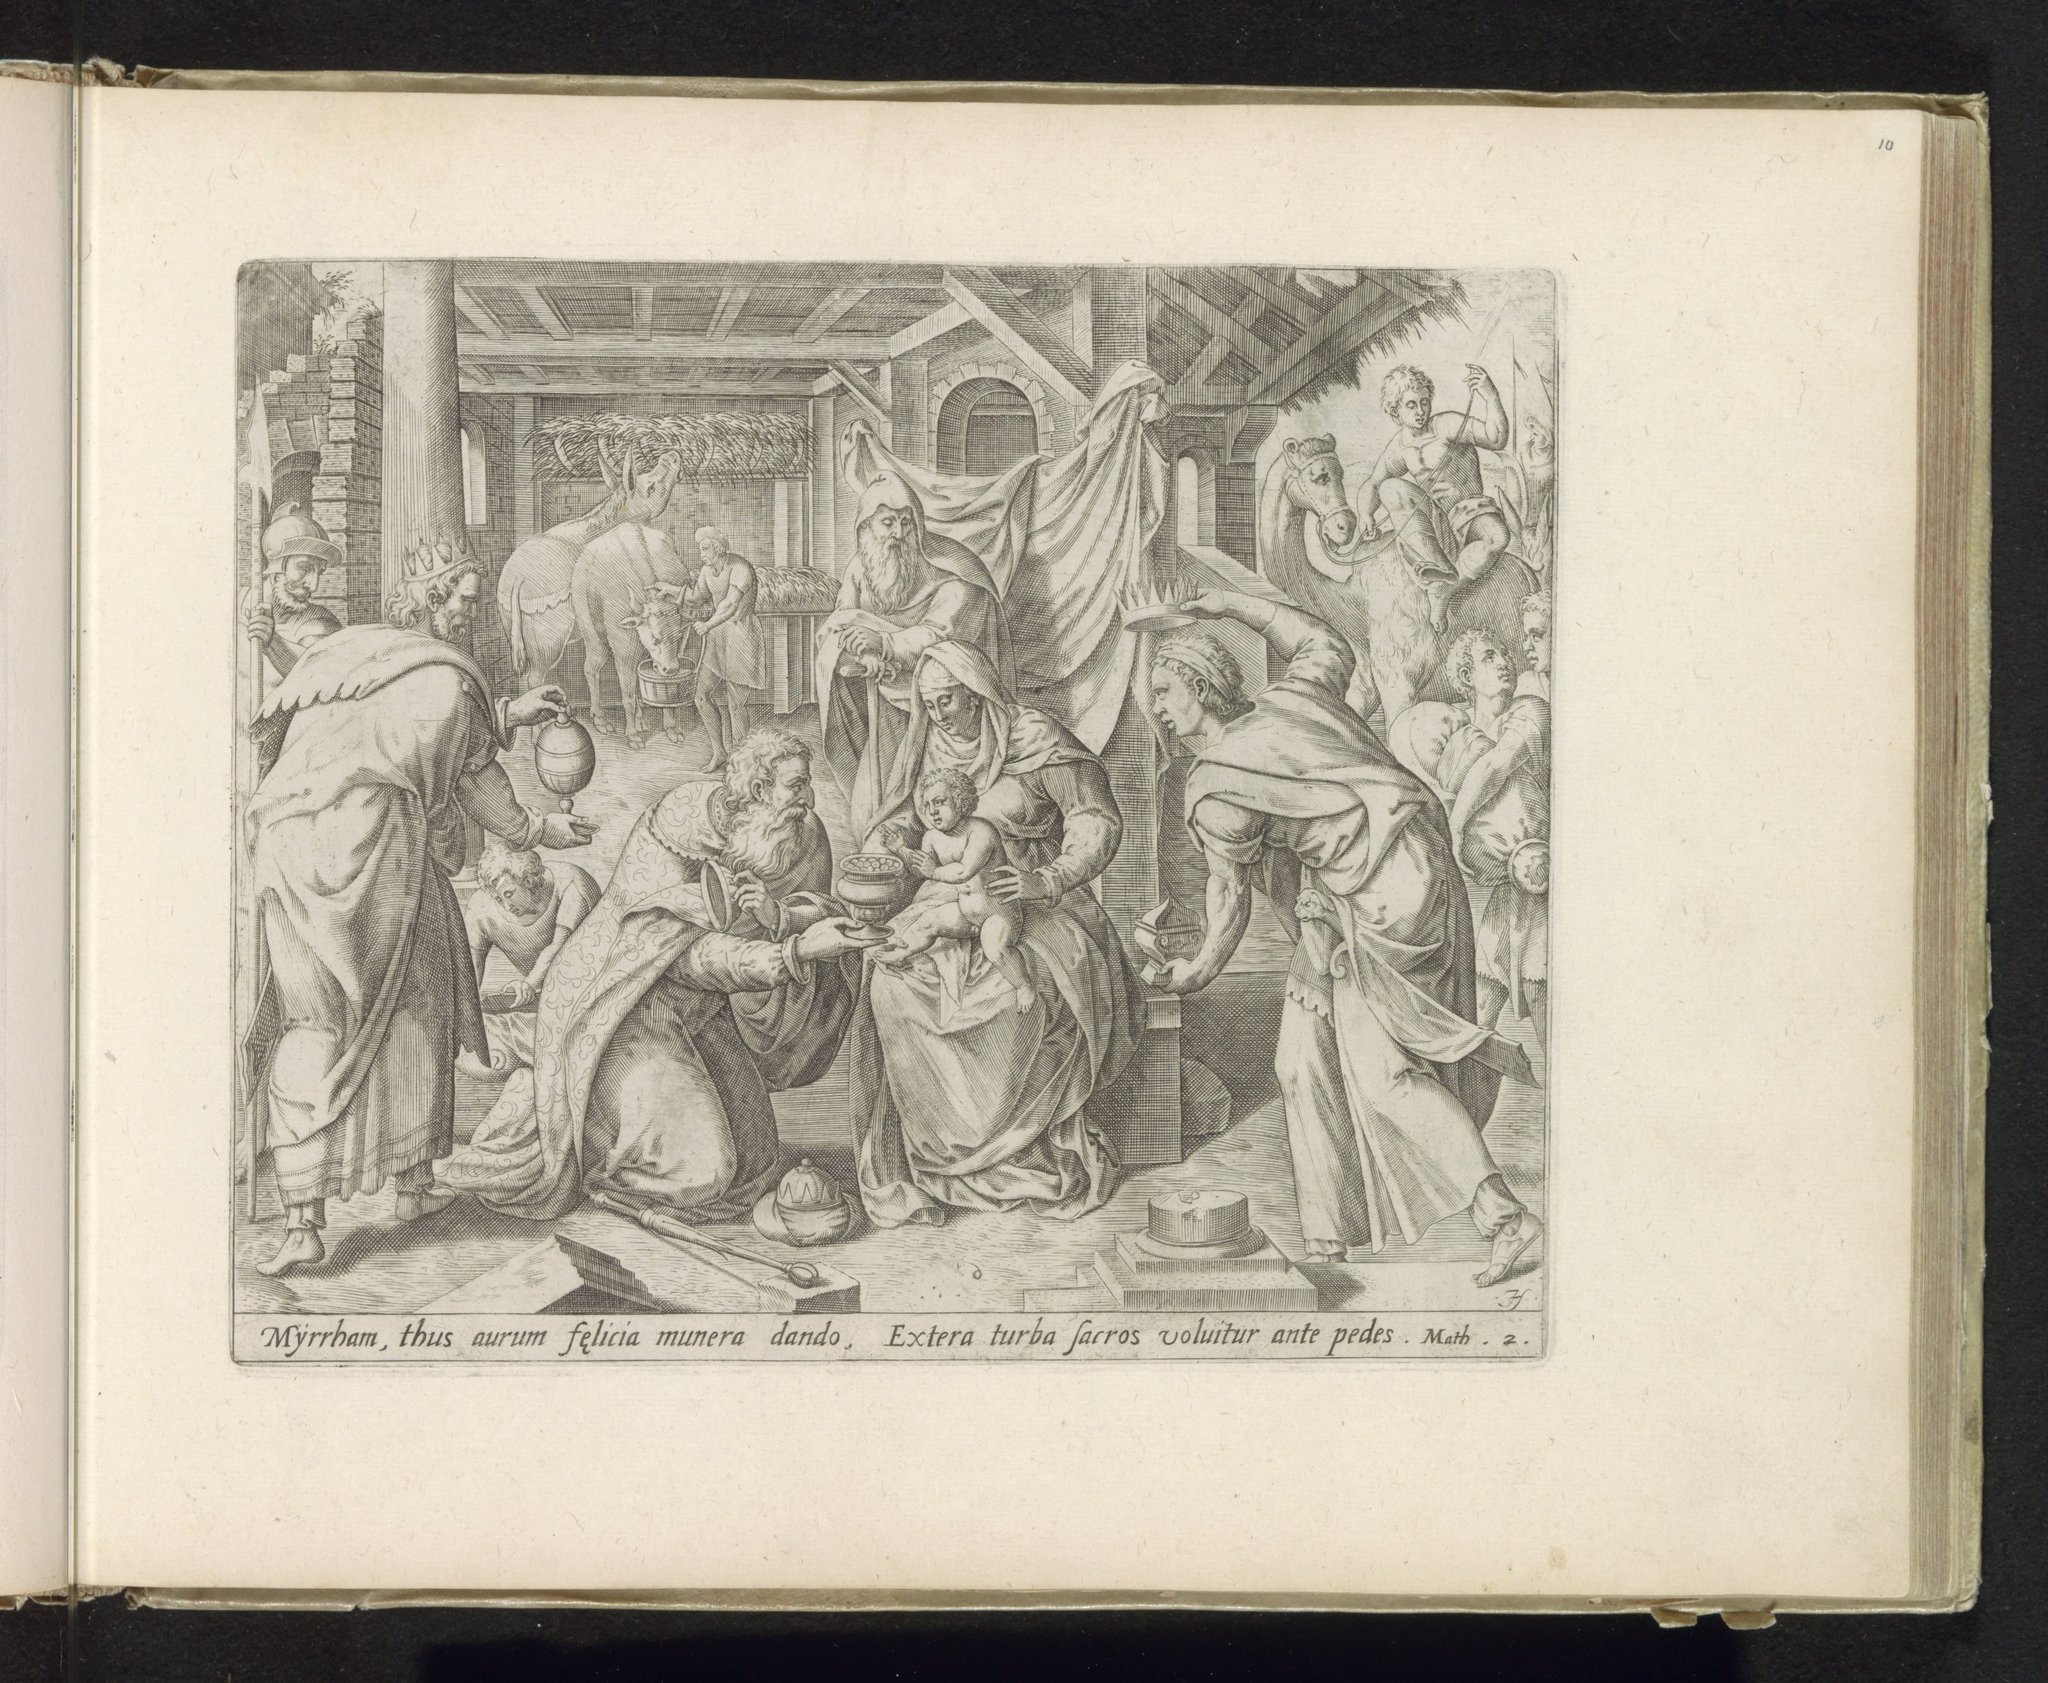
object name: print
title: Jeugd van Christus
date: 1585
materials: paper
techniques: engraving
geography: antwerp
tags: adoration of the kings: the wise men present their gifts to the christ-child (gold, frankincense and myrrh)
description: De drie koningen geven hun geschenken aan het Christuskind, dat bij Maria op schoot zit. Jozef kijkt leunend op zijn staf toe. Op de achtergrond wordt de os gevoerd. Onder de voorstelling een verwijzing in het Latijn naar de Bijbeltekst in Mat. 2. Deze prent maakt deel uit van een album.